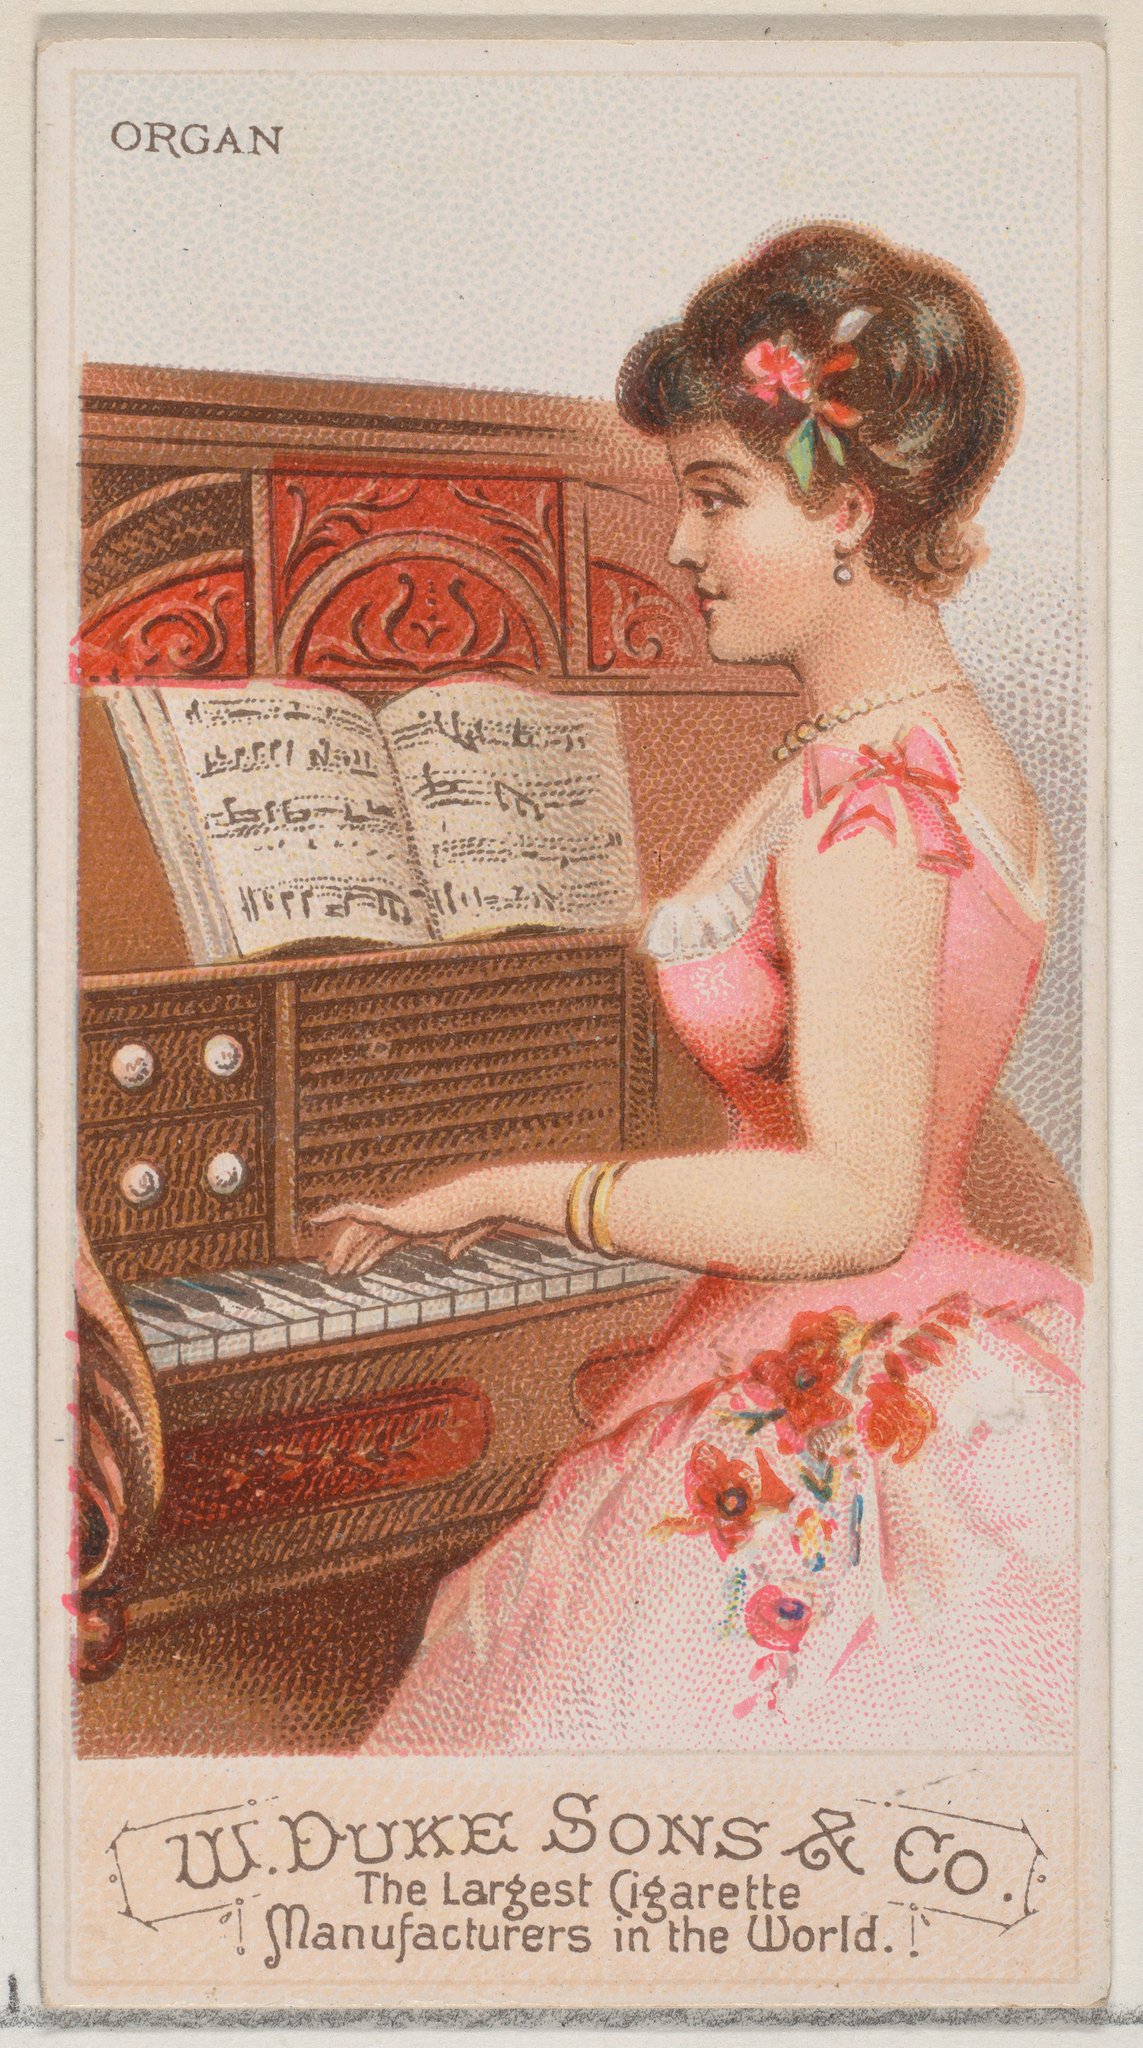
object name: print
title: Organ, from the Musical Instruments series (N82) for Duke brand cigarettes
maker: w. duke, sons & co.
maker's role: publisher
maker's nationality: american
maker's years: 1870-1920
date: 1888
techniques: color lithograph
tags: musical instruments,women,musicians